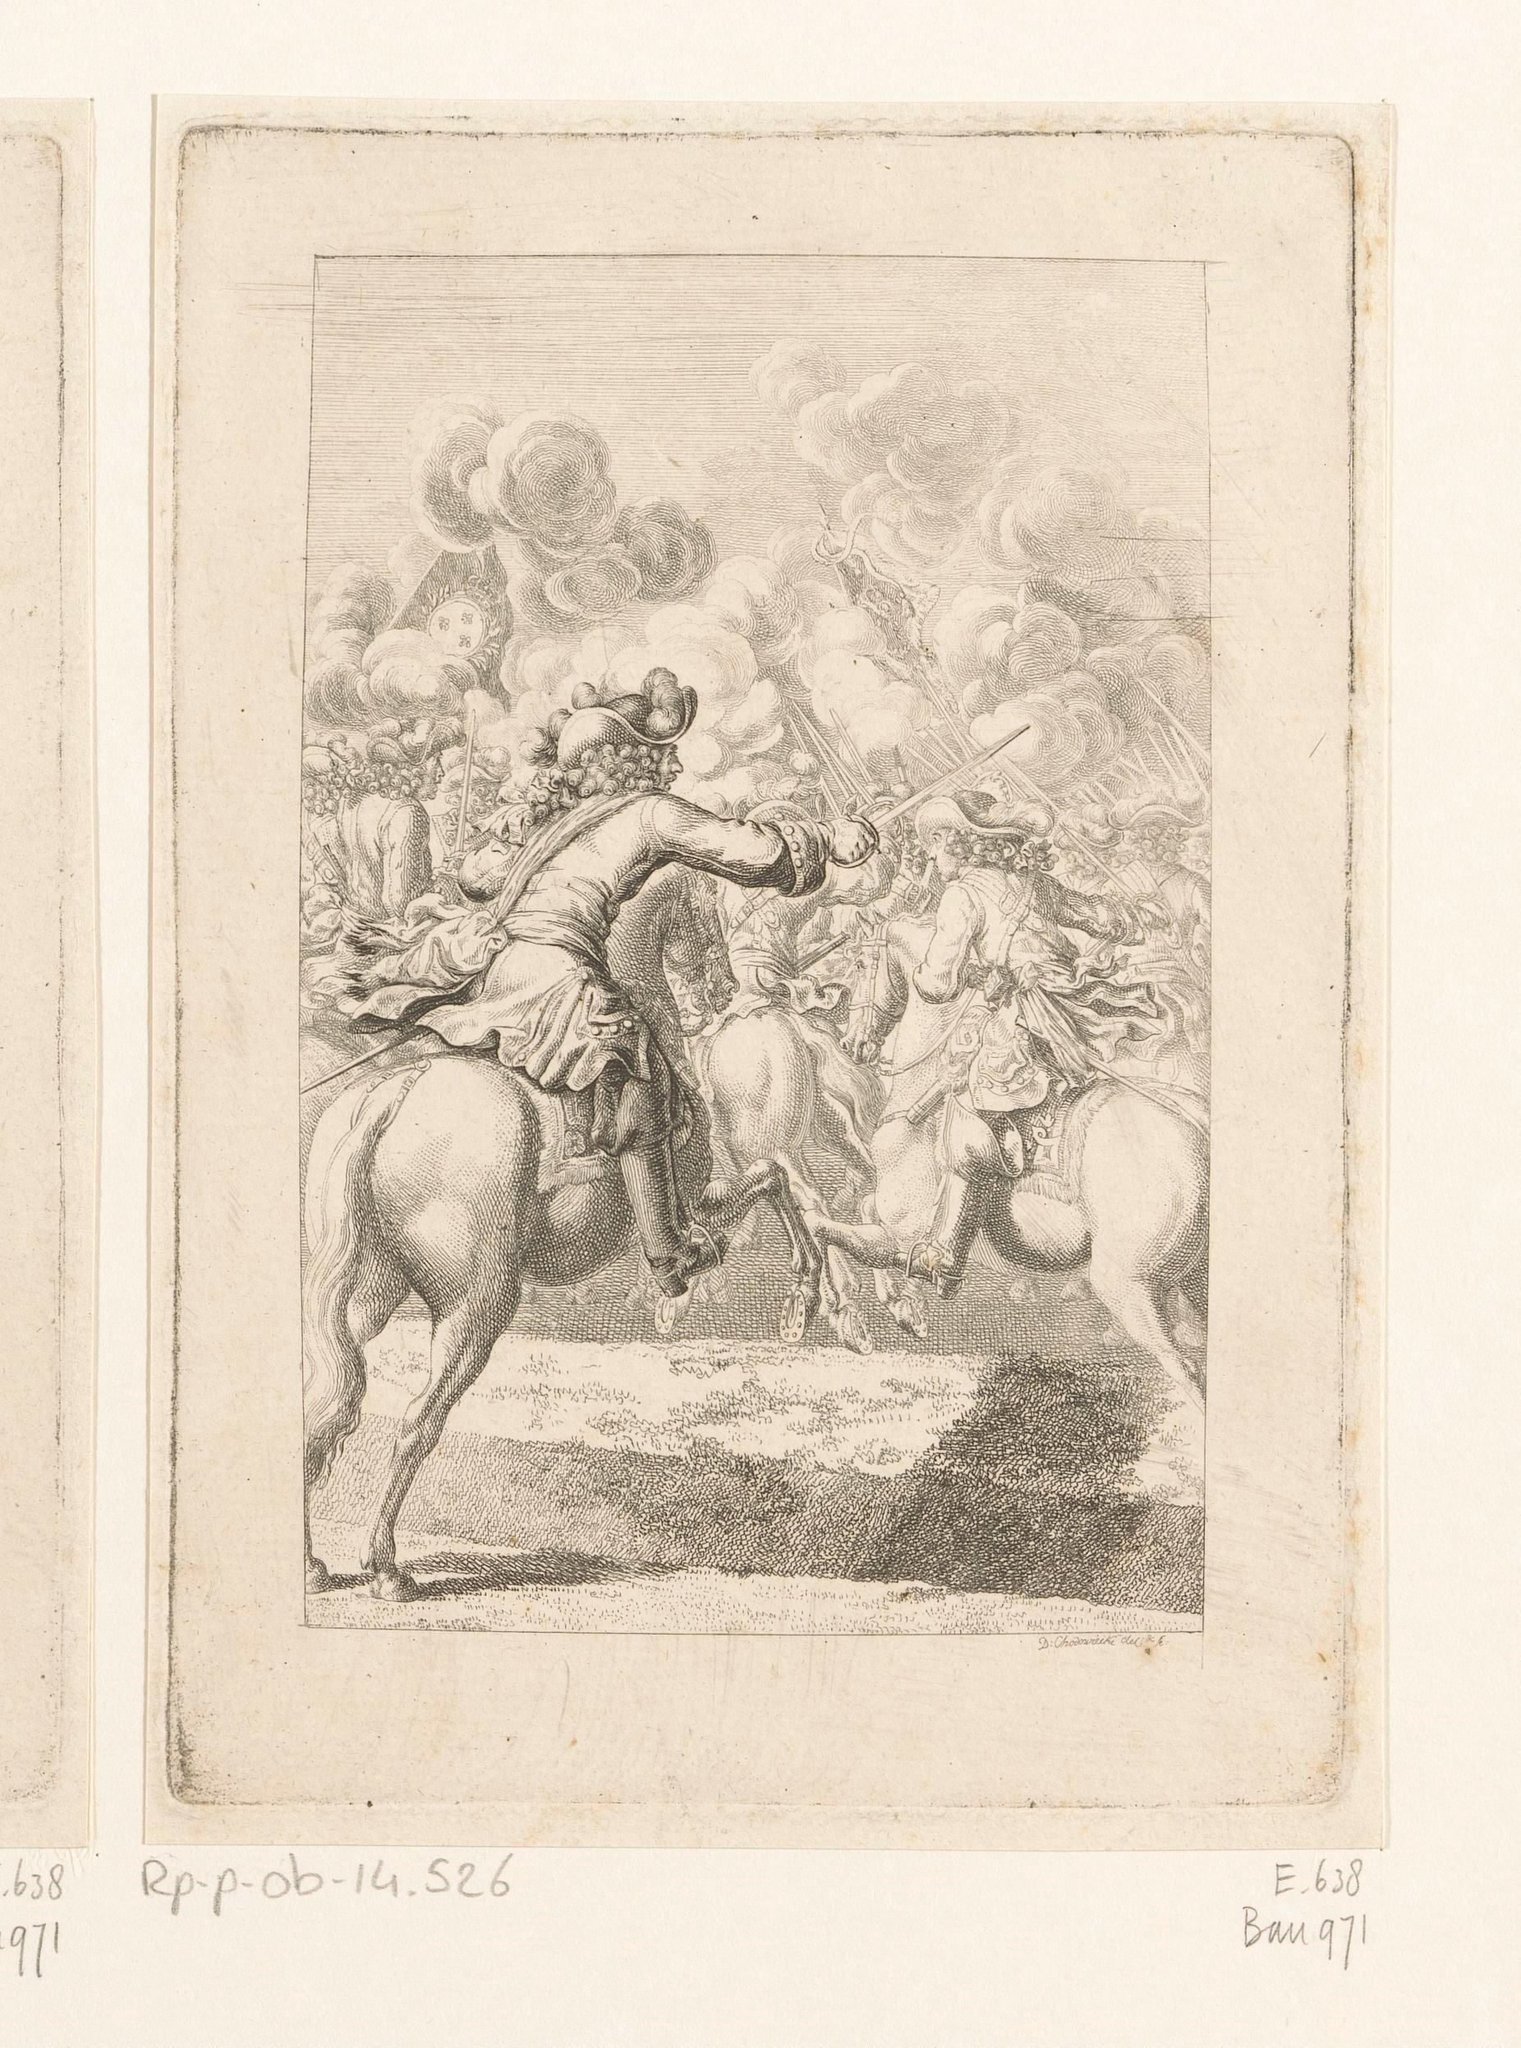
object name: print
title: Friedrich III op het slagveld tijdens de negenjarige oorlog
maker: daniel nikolaus chodowiecki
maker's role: draughtsman, print maker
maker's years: 1726-1801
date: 1790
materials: paper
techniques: etching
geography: berlin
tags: berlin, frederik willem van brandenburg (i), riding a horse, ass, or mule; rider, horseman, hacking and thrusting weapons: sword, charge ~ battle, flag, colours (as symbol of the state, etc.)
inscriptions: collector's mark: Lugt 2228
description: Prent gebruikt voor: Erman, Jean Pierre. Mémoires pour servir à l'histoire des réfugiés françois dans les états du roi. 9 dln. Berlijn: s.n., 1790, dl. 7.